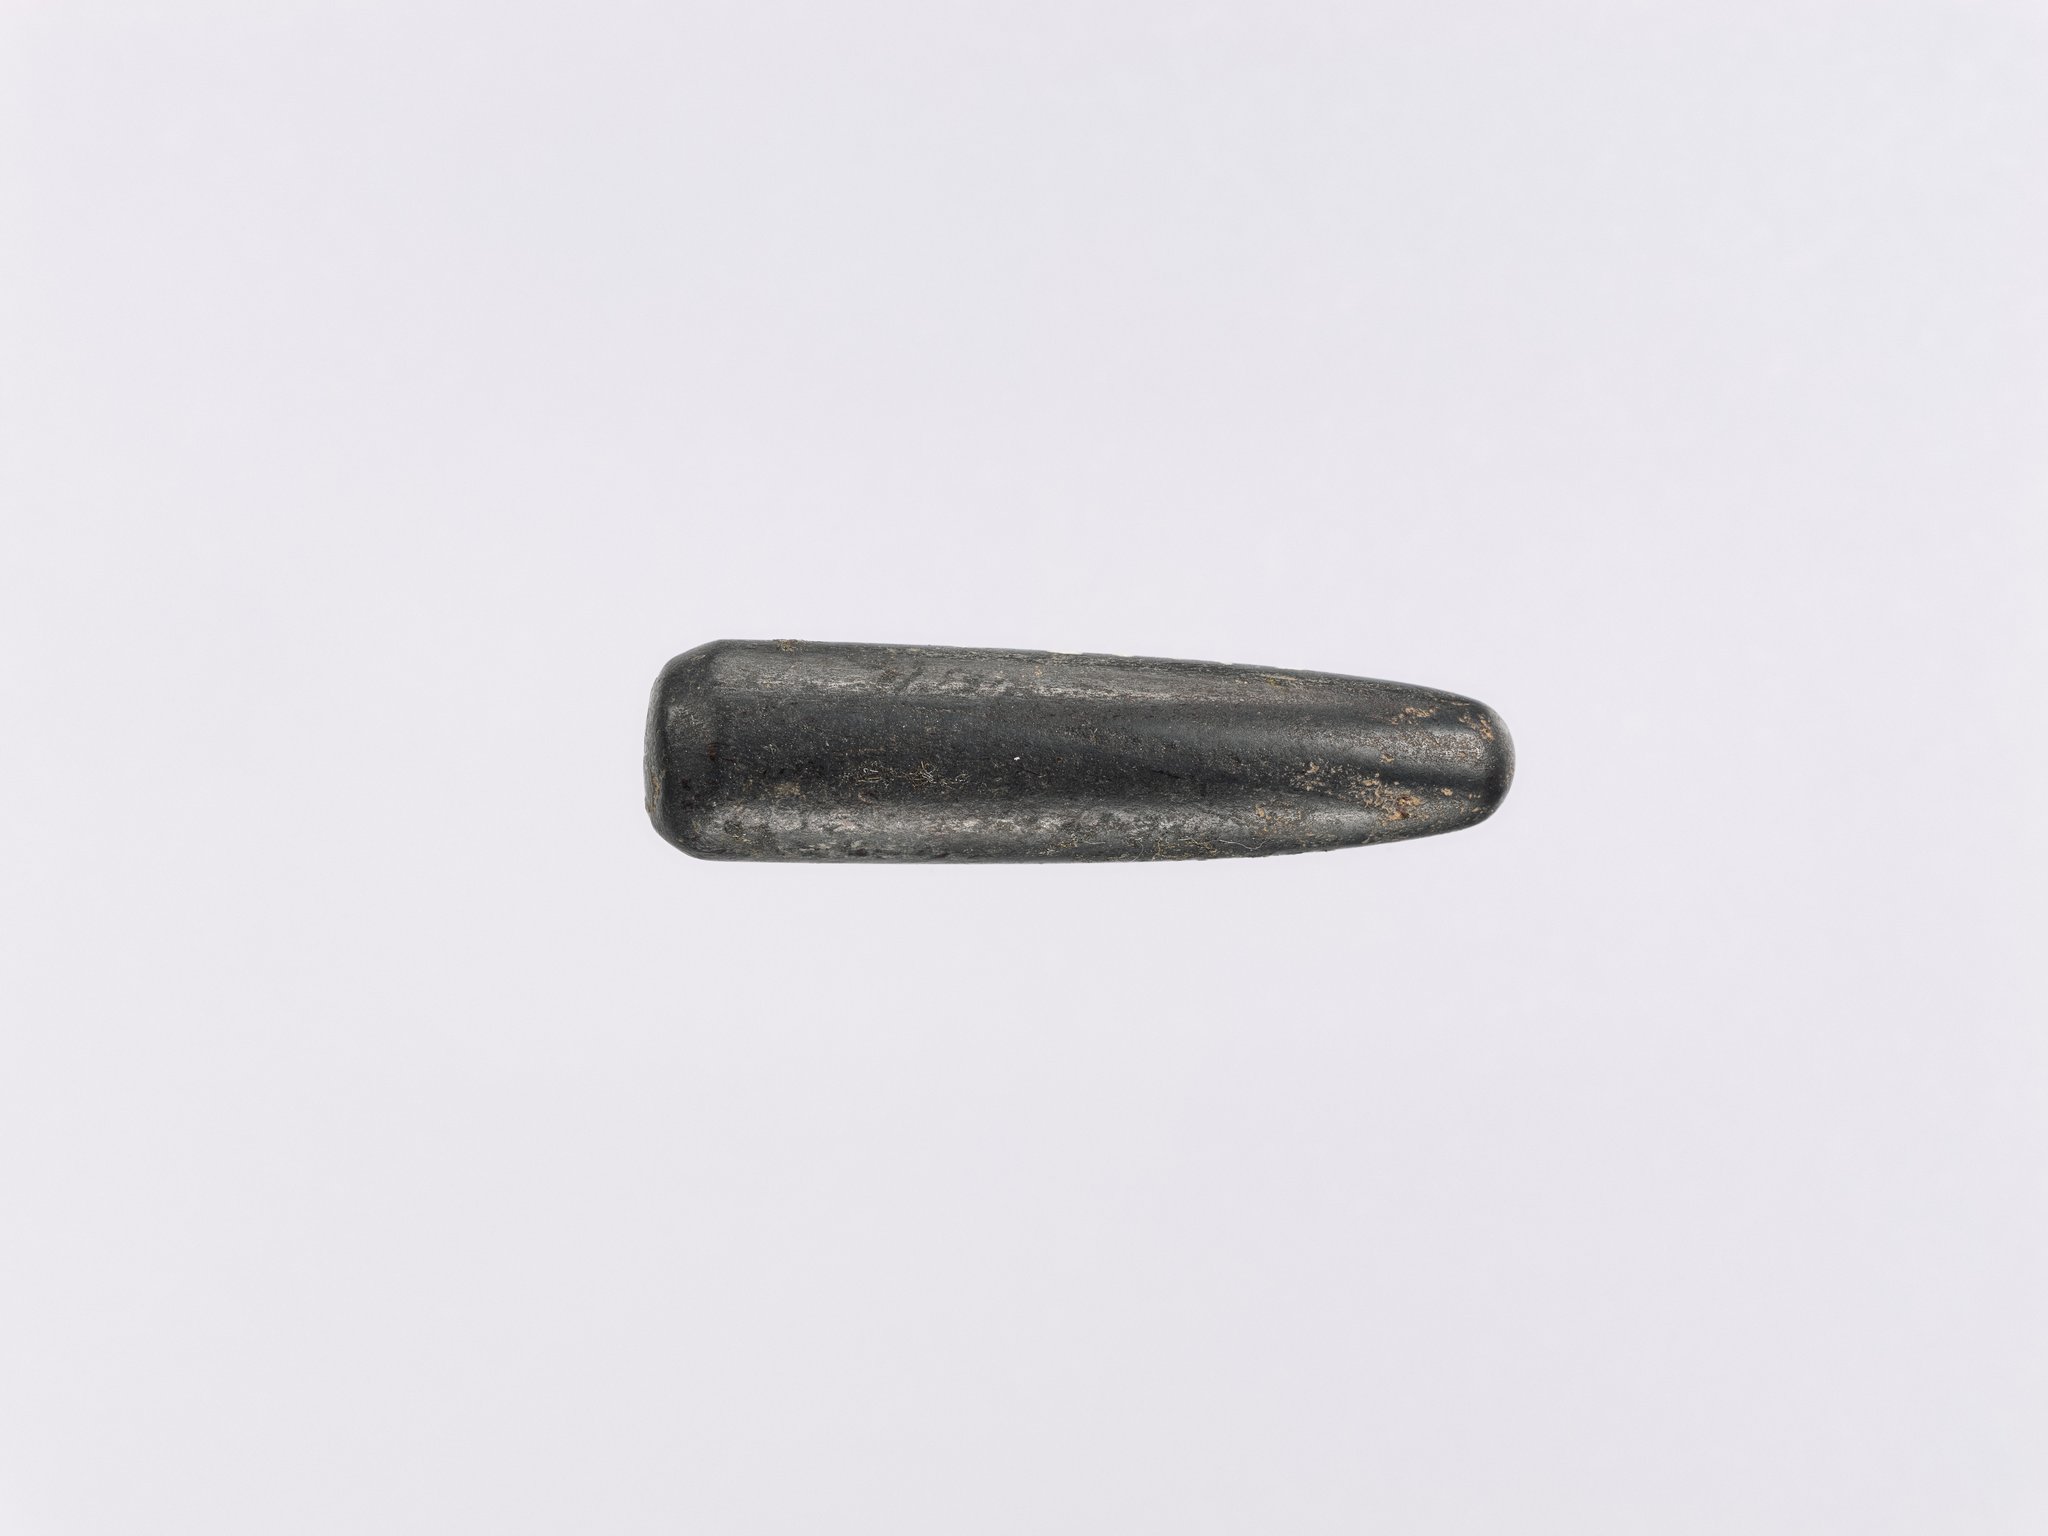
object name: weight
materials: mineral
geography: mesopotamia